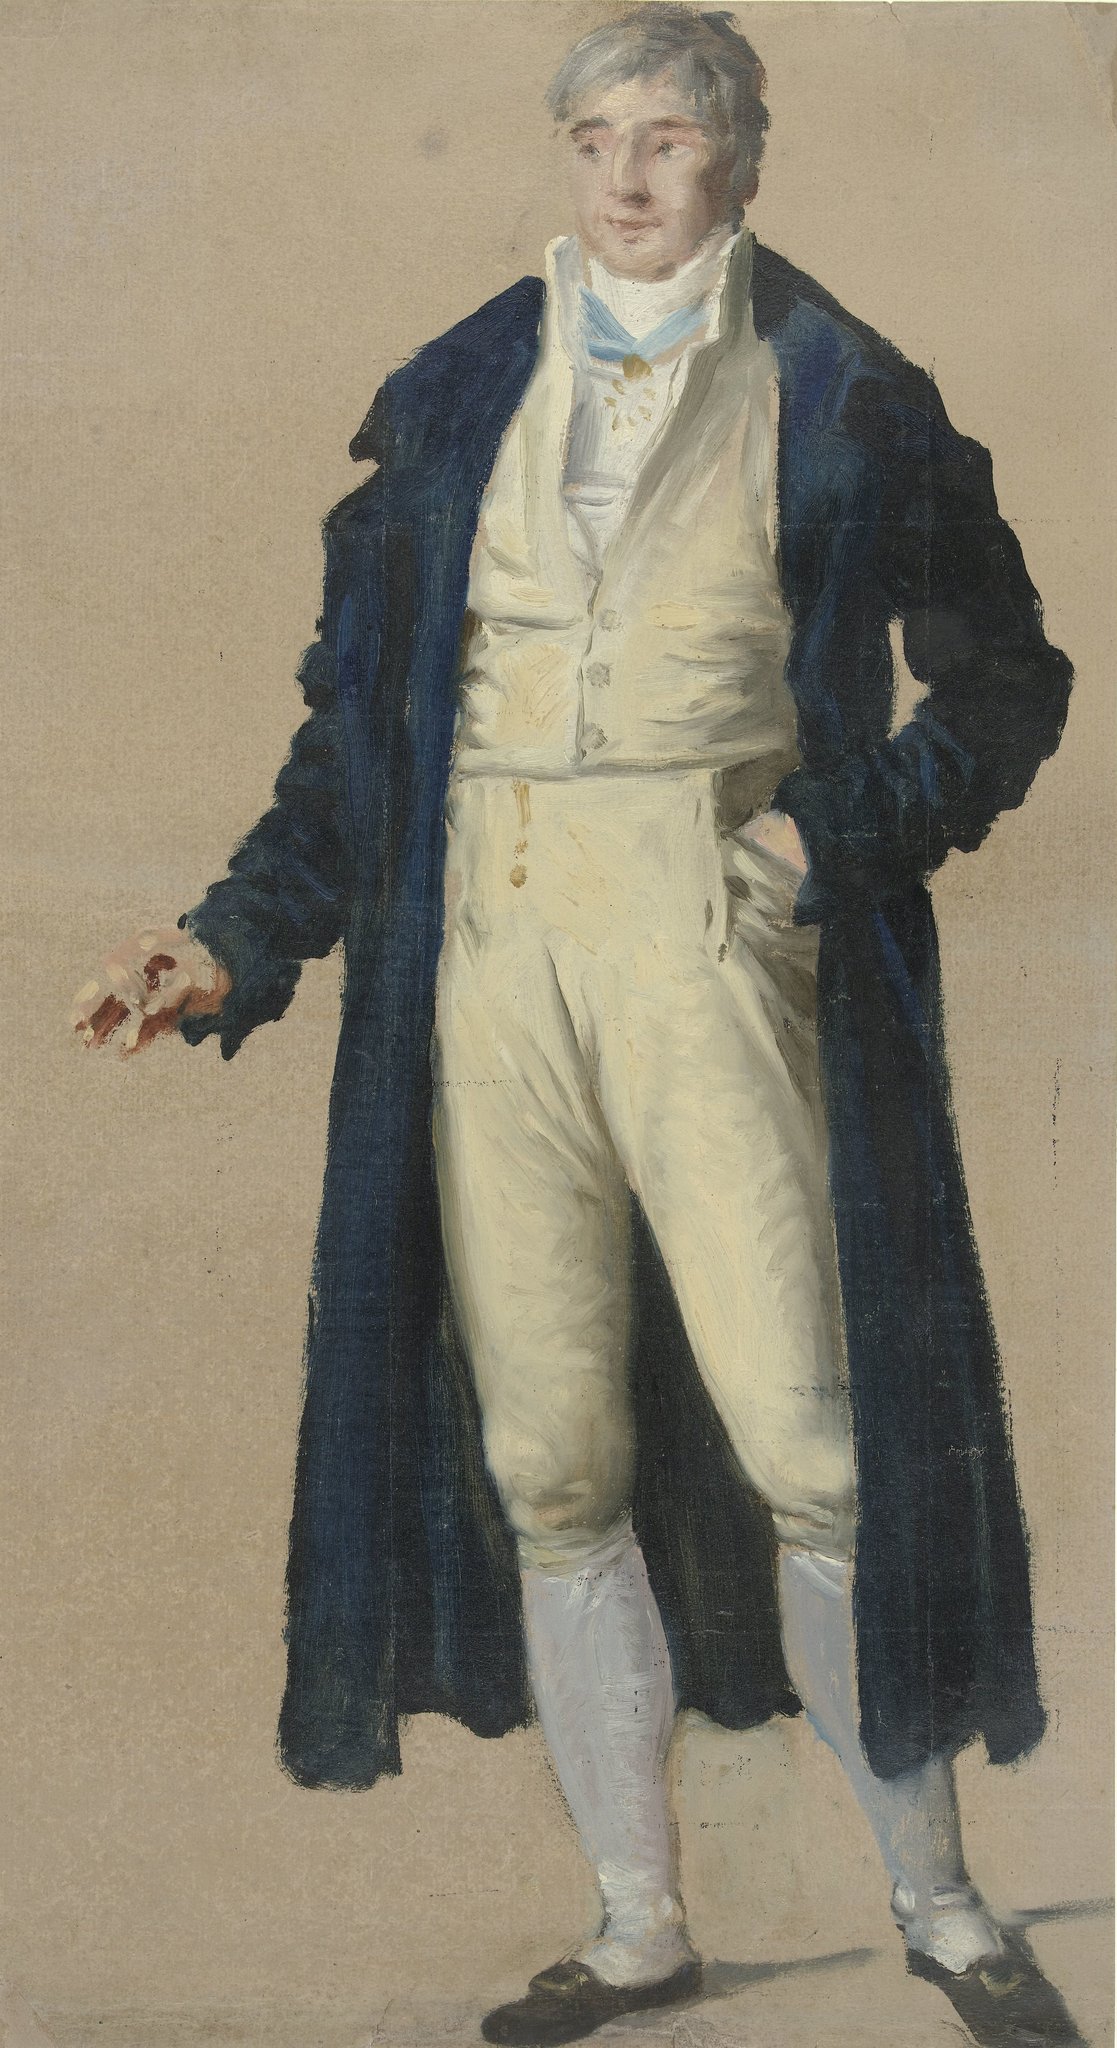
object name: drawing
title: Portret van de Comte de Toqueville, ten voeten uit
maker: Anonymous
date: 1800-1900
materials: oil, paper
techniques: brush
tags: historical persons